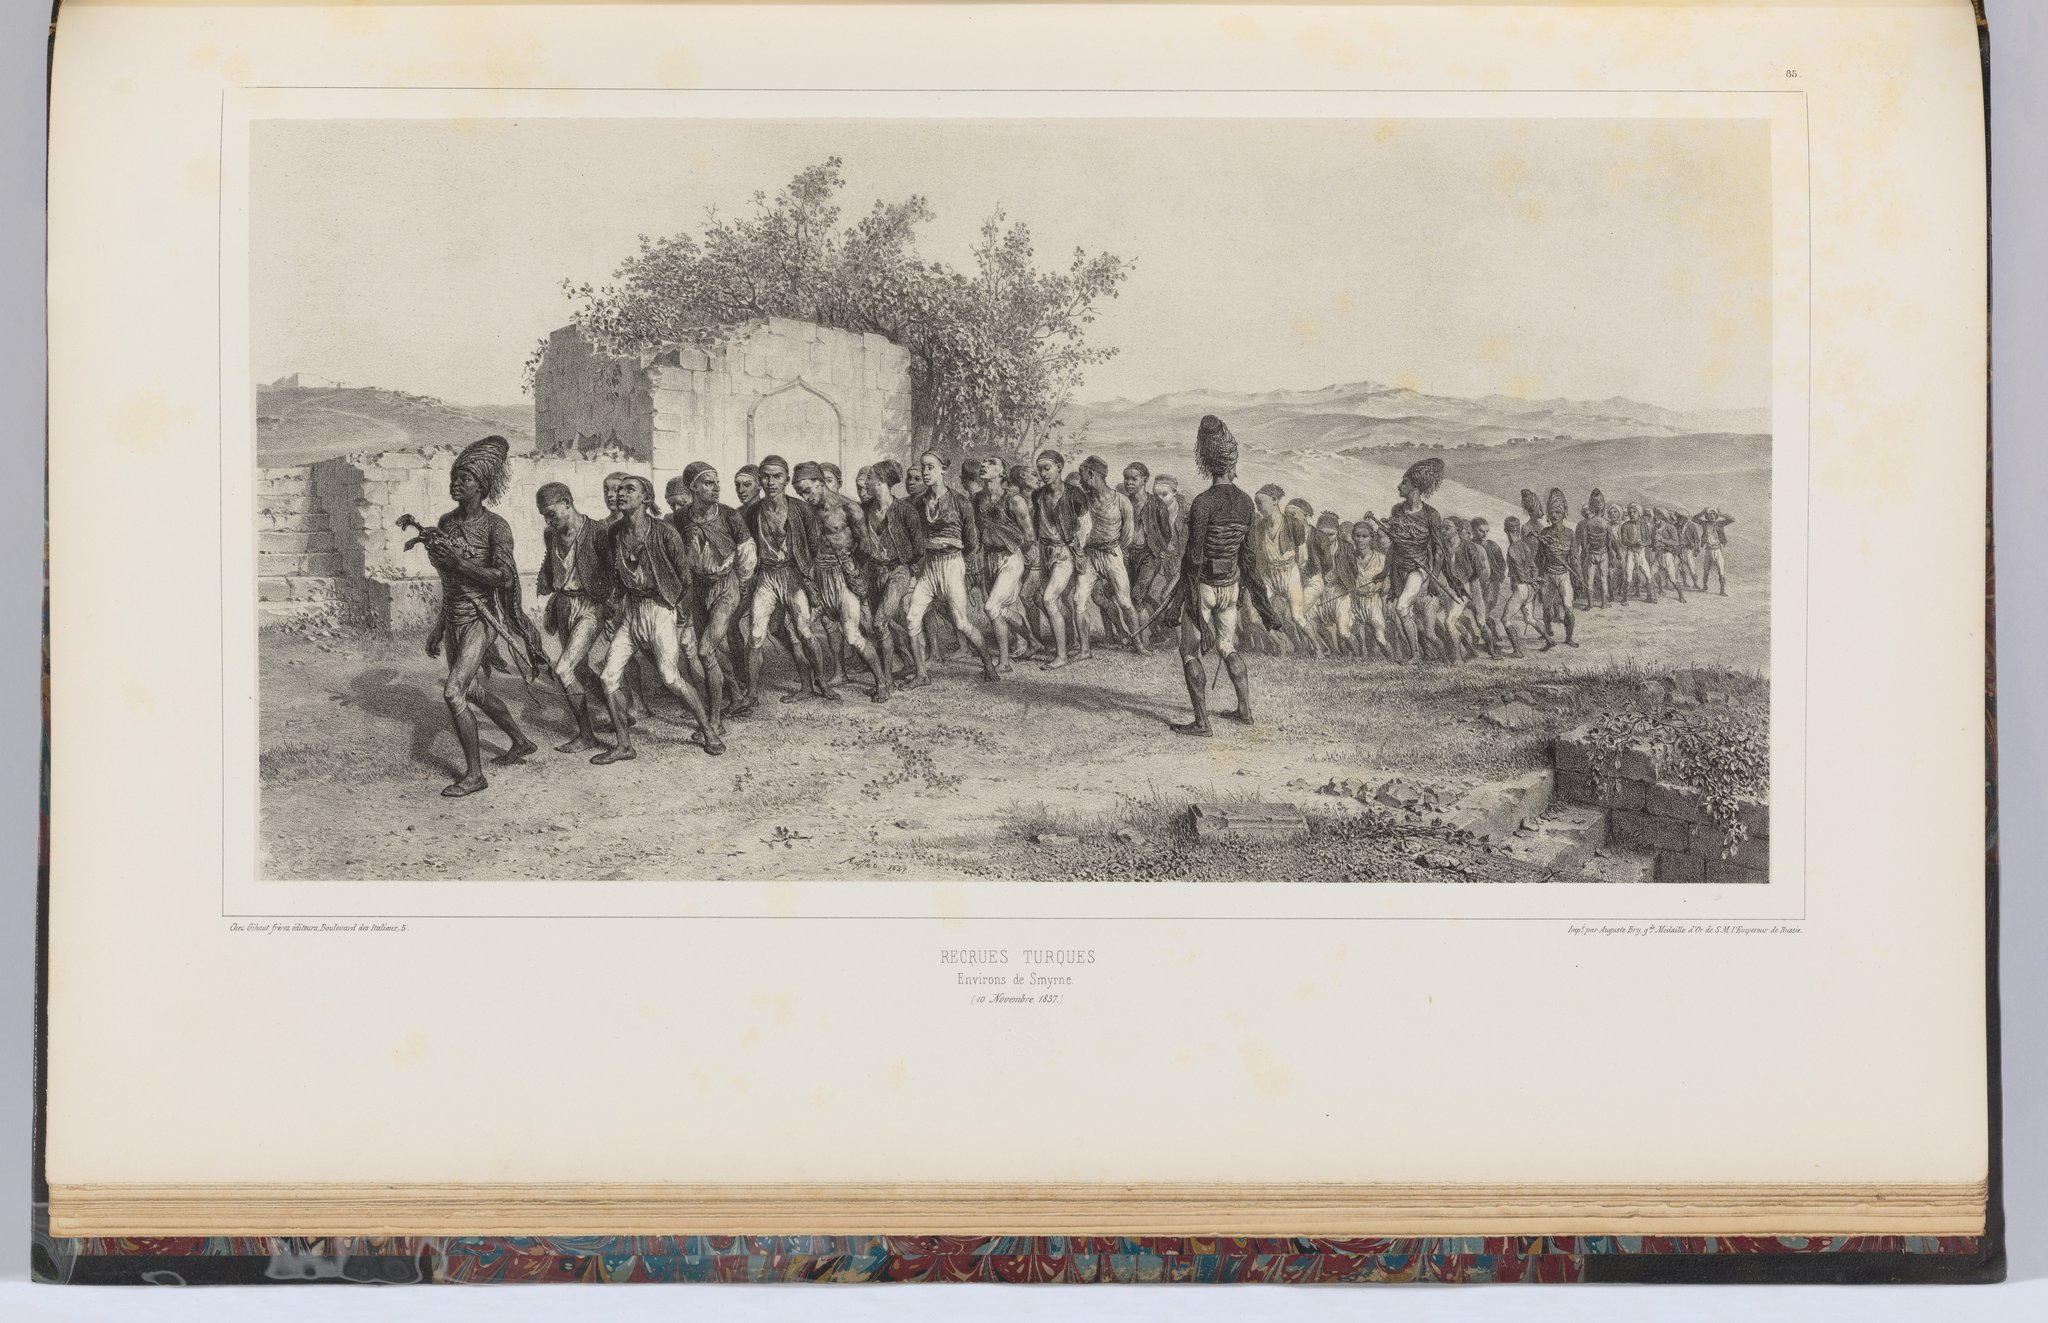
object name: book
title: Voyage dans la Russie Méridionale & la Crimée par La Hongrie, La Valachie et La Moldavie en 1837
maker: anatoly n. demidov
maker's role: editor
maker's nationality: russian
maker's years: 1813-1870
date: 1848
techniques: lithograph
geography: france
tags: men